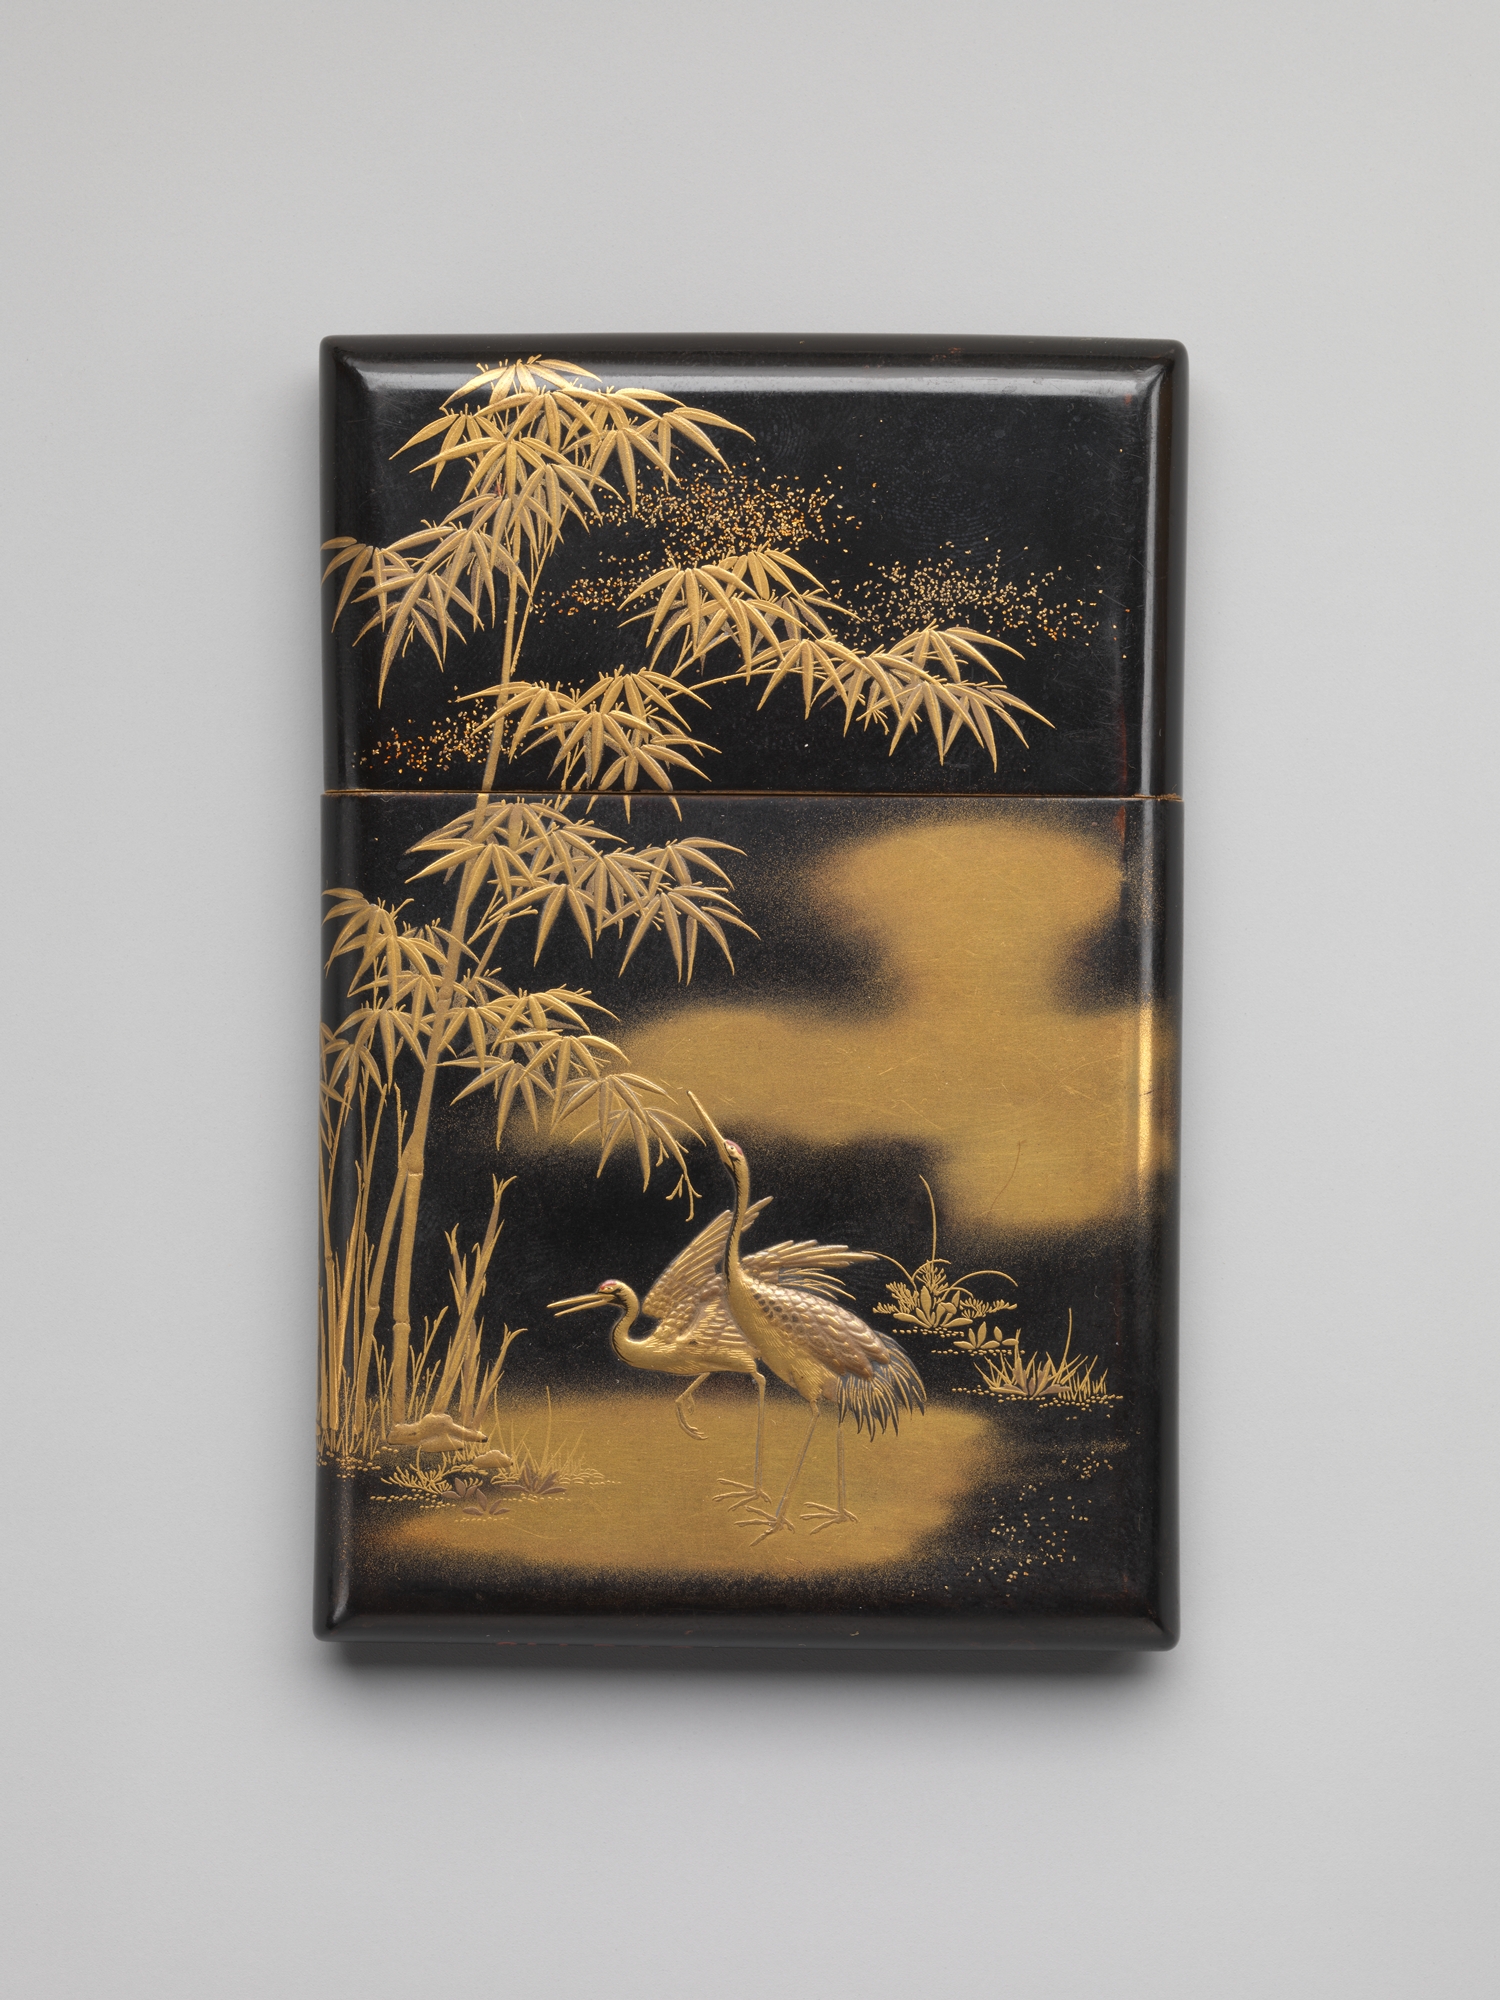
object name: card case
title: Card Case with Crane and Bamboo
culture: japanese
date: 1834-1866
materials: gold, lacquer, silver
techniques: hiramakie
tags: cranes,bamboo